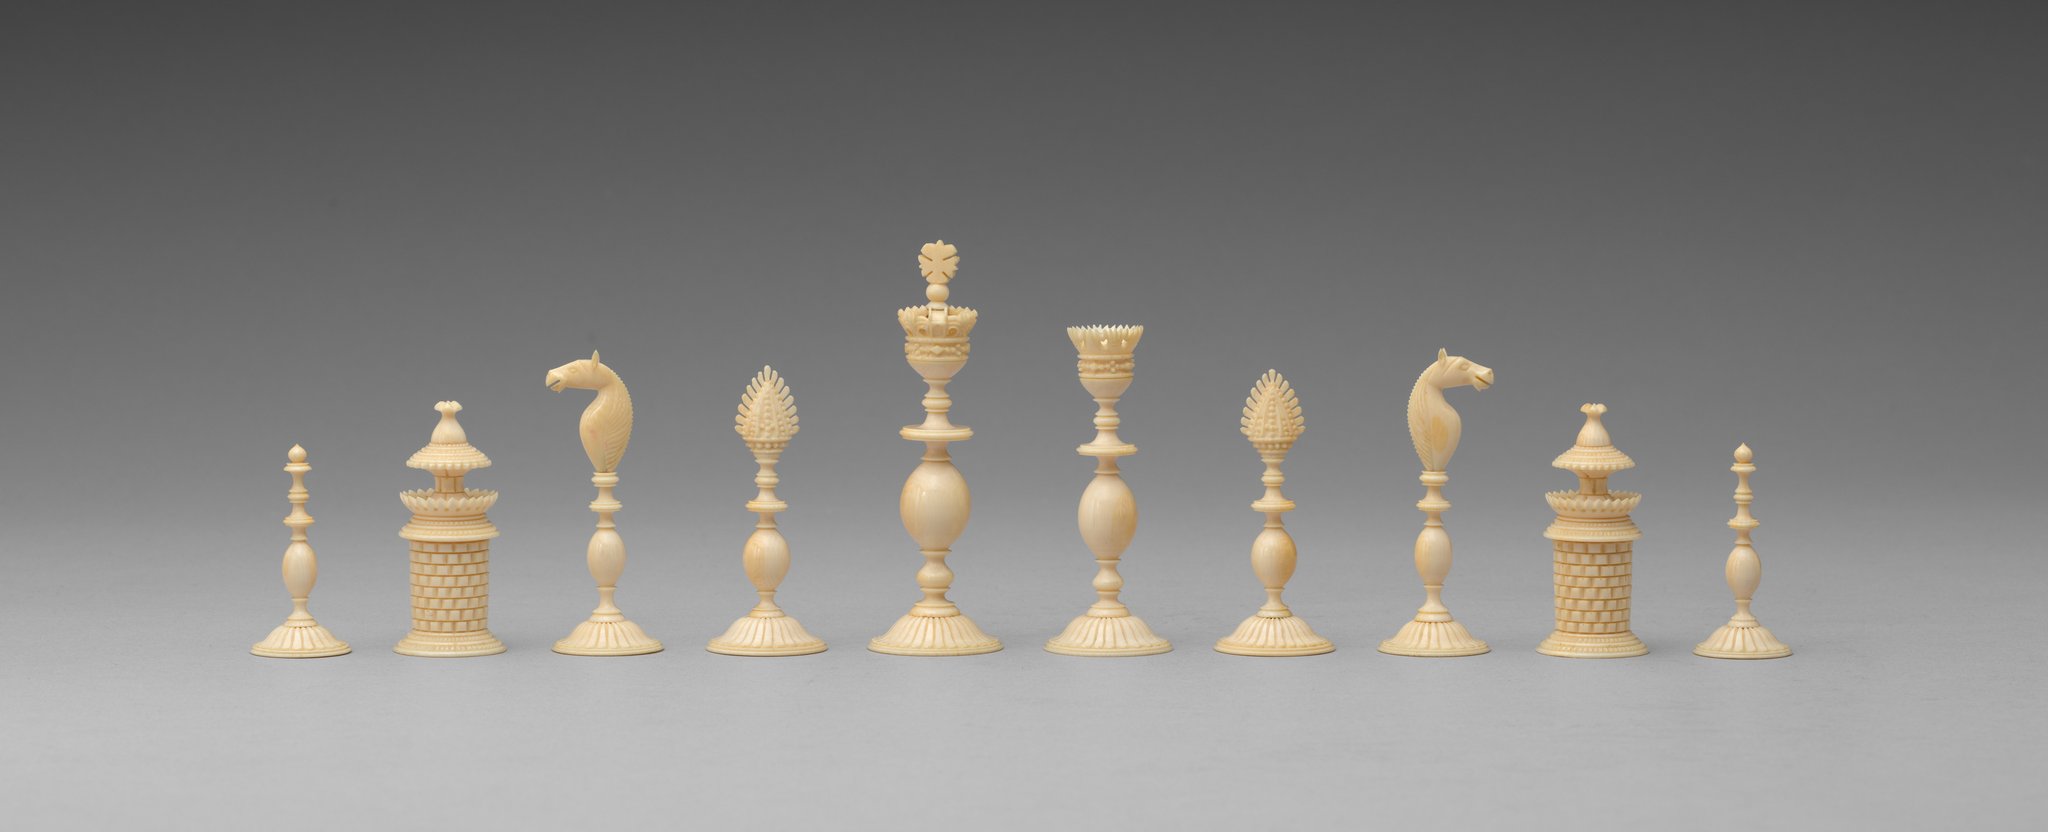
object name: chessman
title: Chessmen (32)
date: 1801-1900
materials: ivory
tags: chess,games